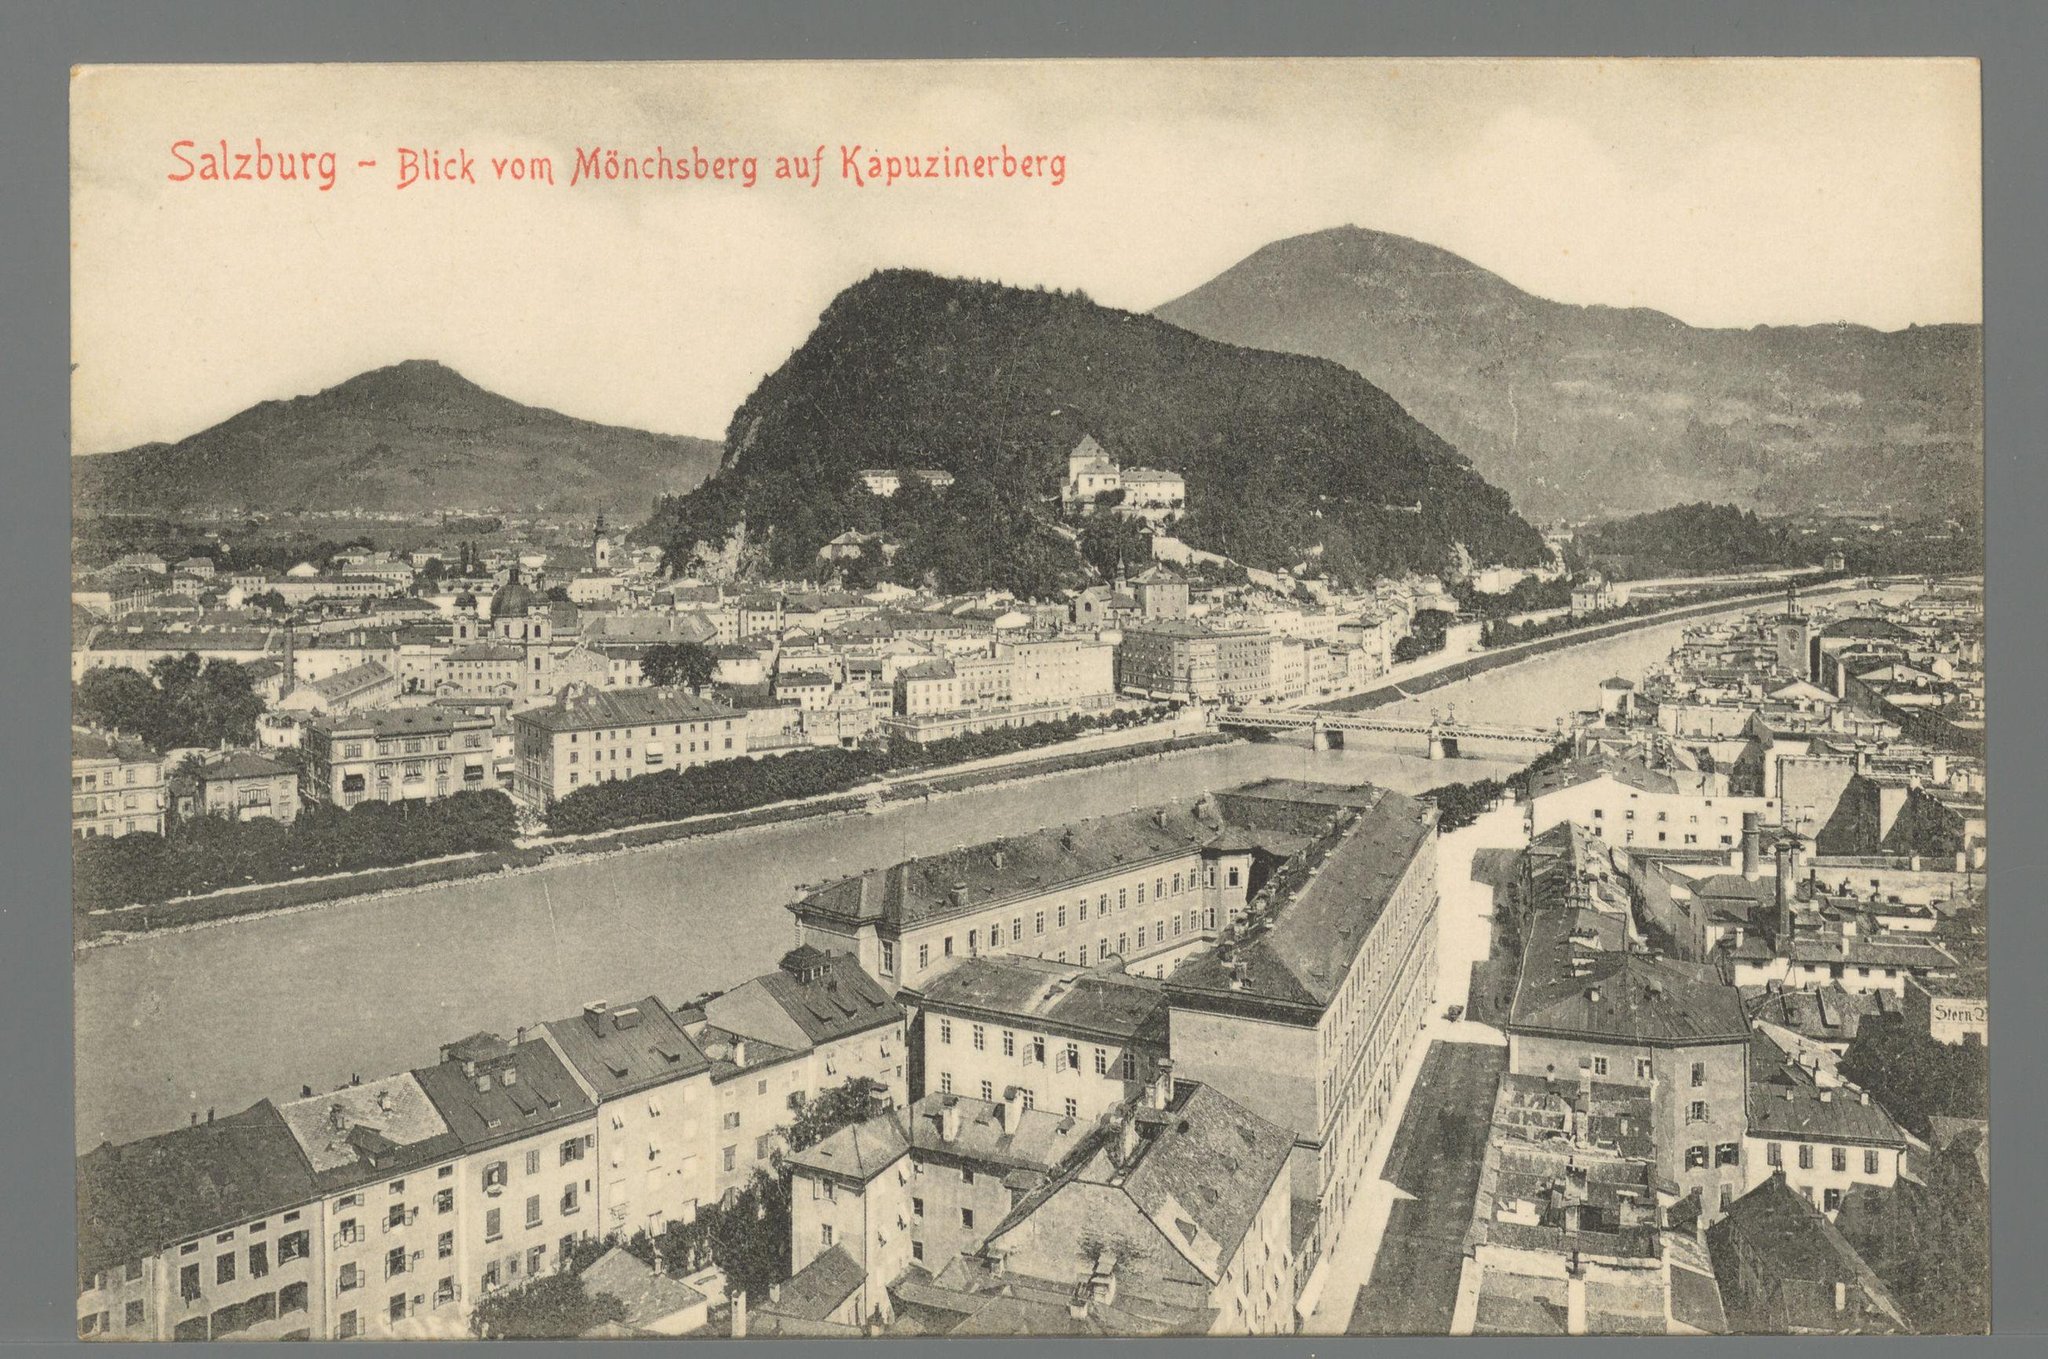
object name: ansichtkaart, prentbriefkaart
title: Salzburg - Blick vom Mönchsberg auf Kapuzinerberg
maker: Anonymous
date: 1900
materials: cardboard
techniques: photograph, writing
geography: salzburg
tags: city-view, and landscape with man-made constructions, canals, waters (in city), mountains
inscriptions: date